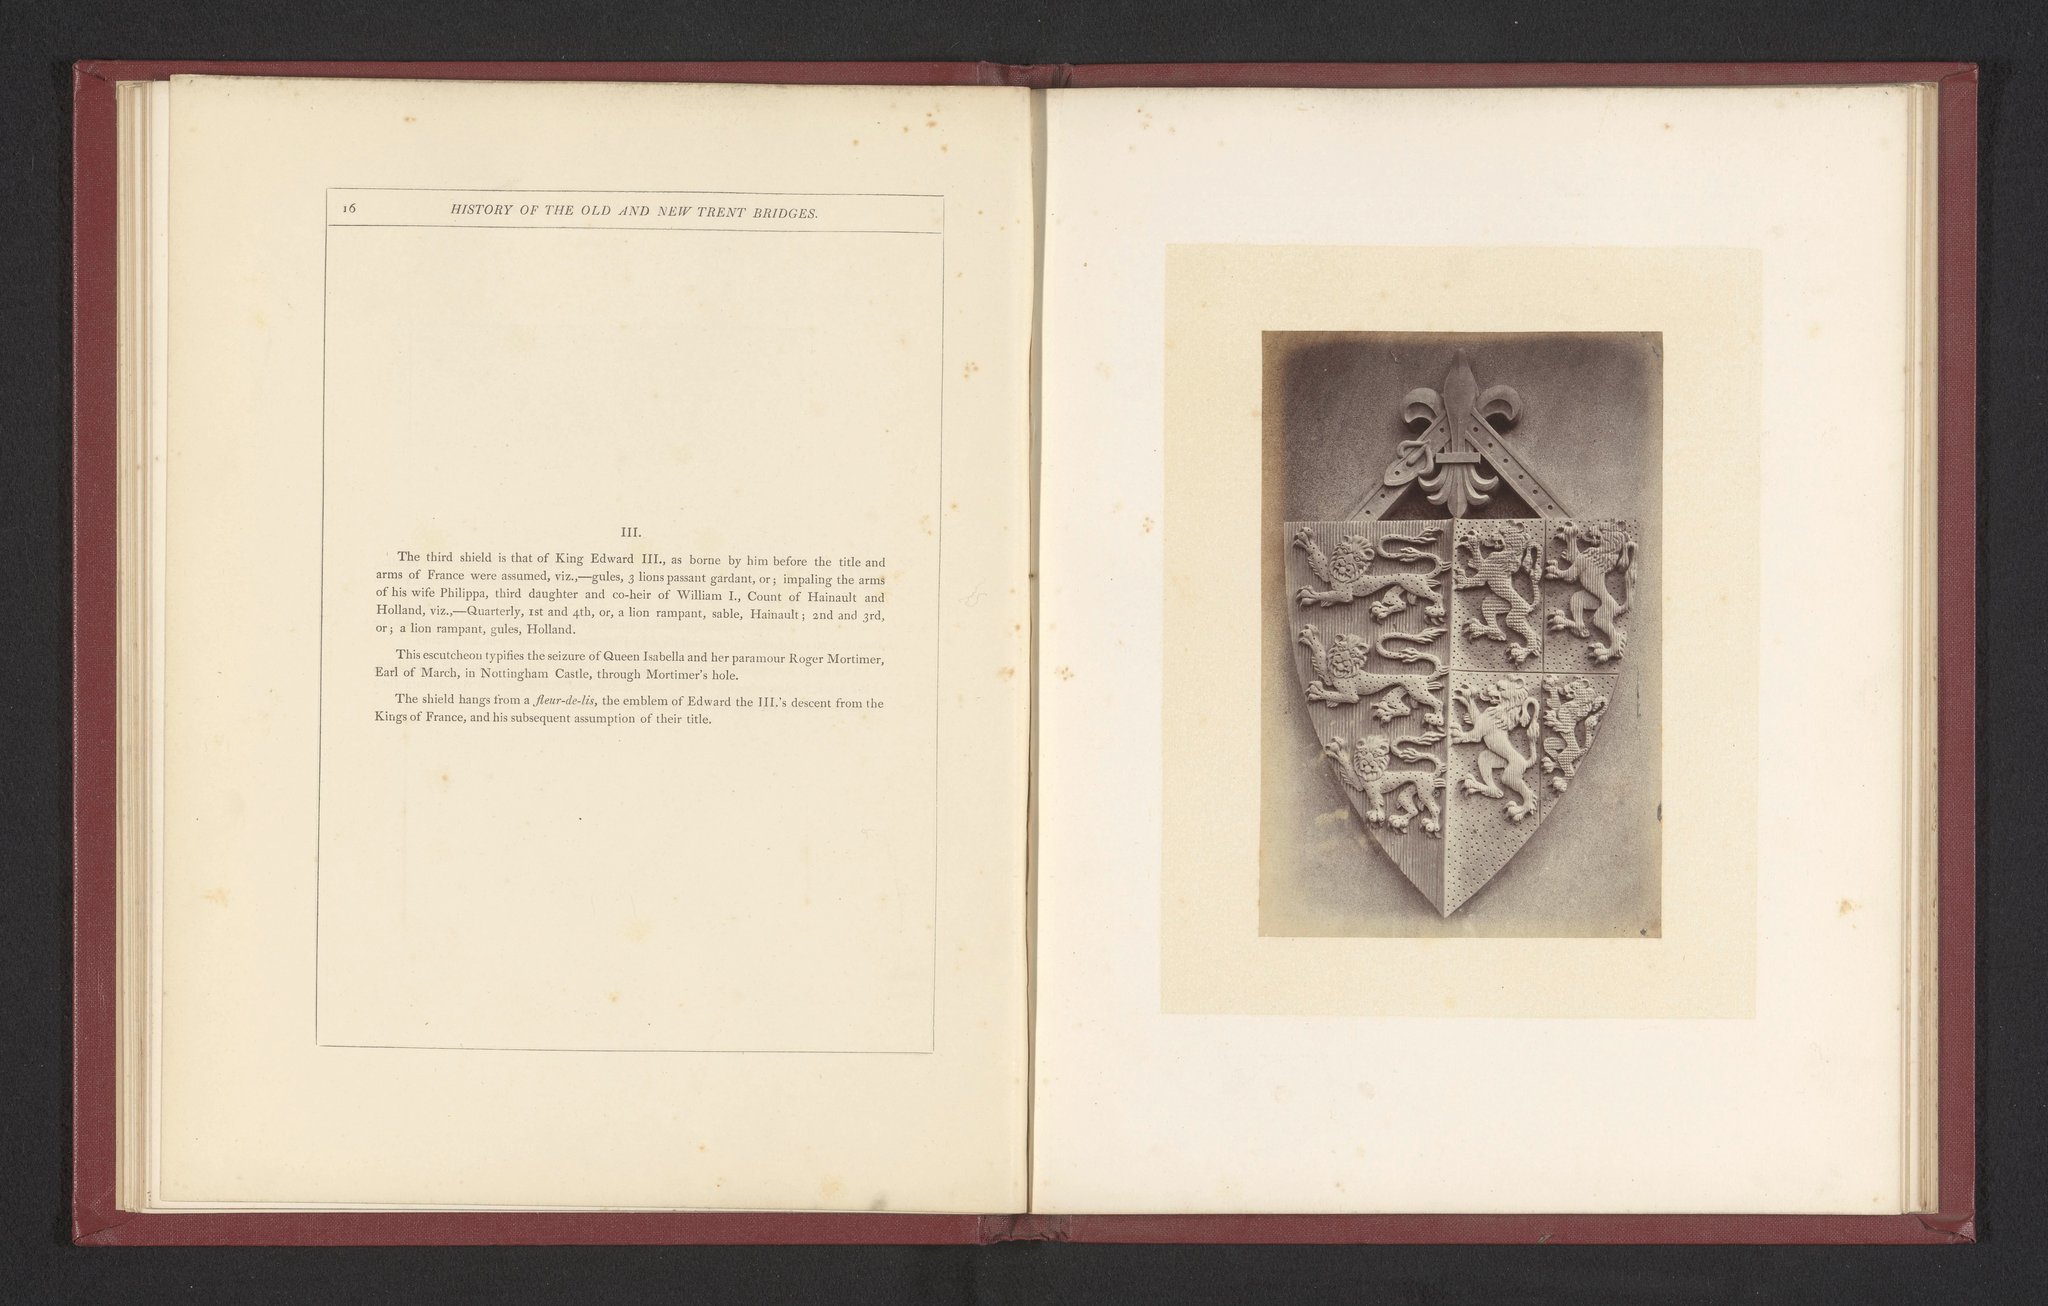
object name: photograph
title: Wapenschild met de tekens van Eduard III van Engeland en zijn vrouw op de Trent Bridge in Nottingham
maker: Anonymous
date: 1871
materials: photographic support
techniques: albumen print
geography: nottingham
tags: coat of arms (as symbol of the state, etc.), bridge in city across river, canal, etc.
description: Links drie leeuwen, rechts vier leeuwen, boven een fleur-de-lys.